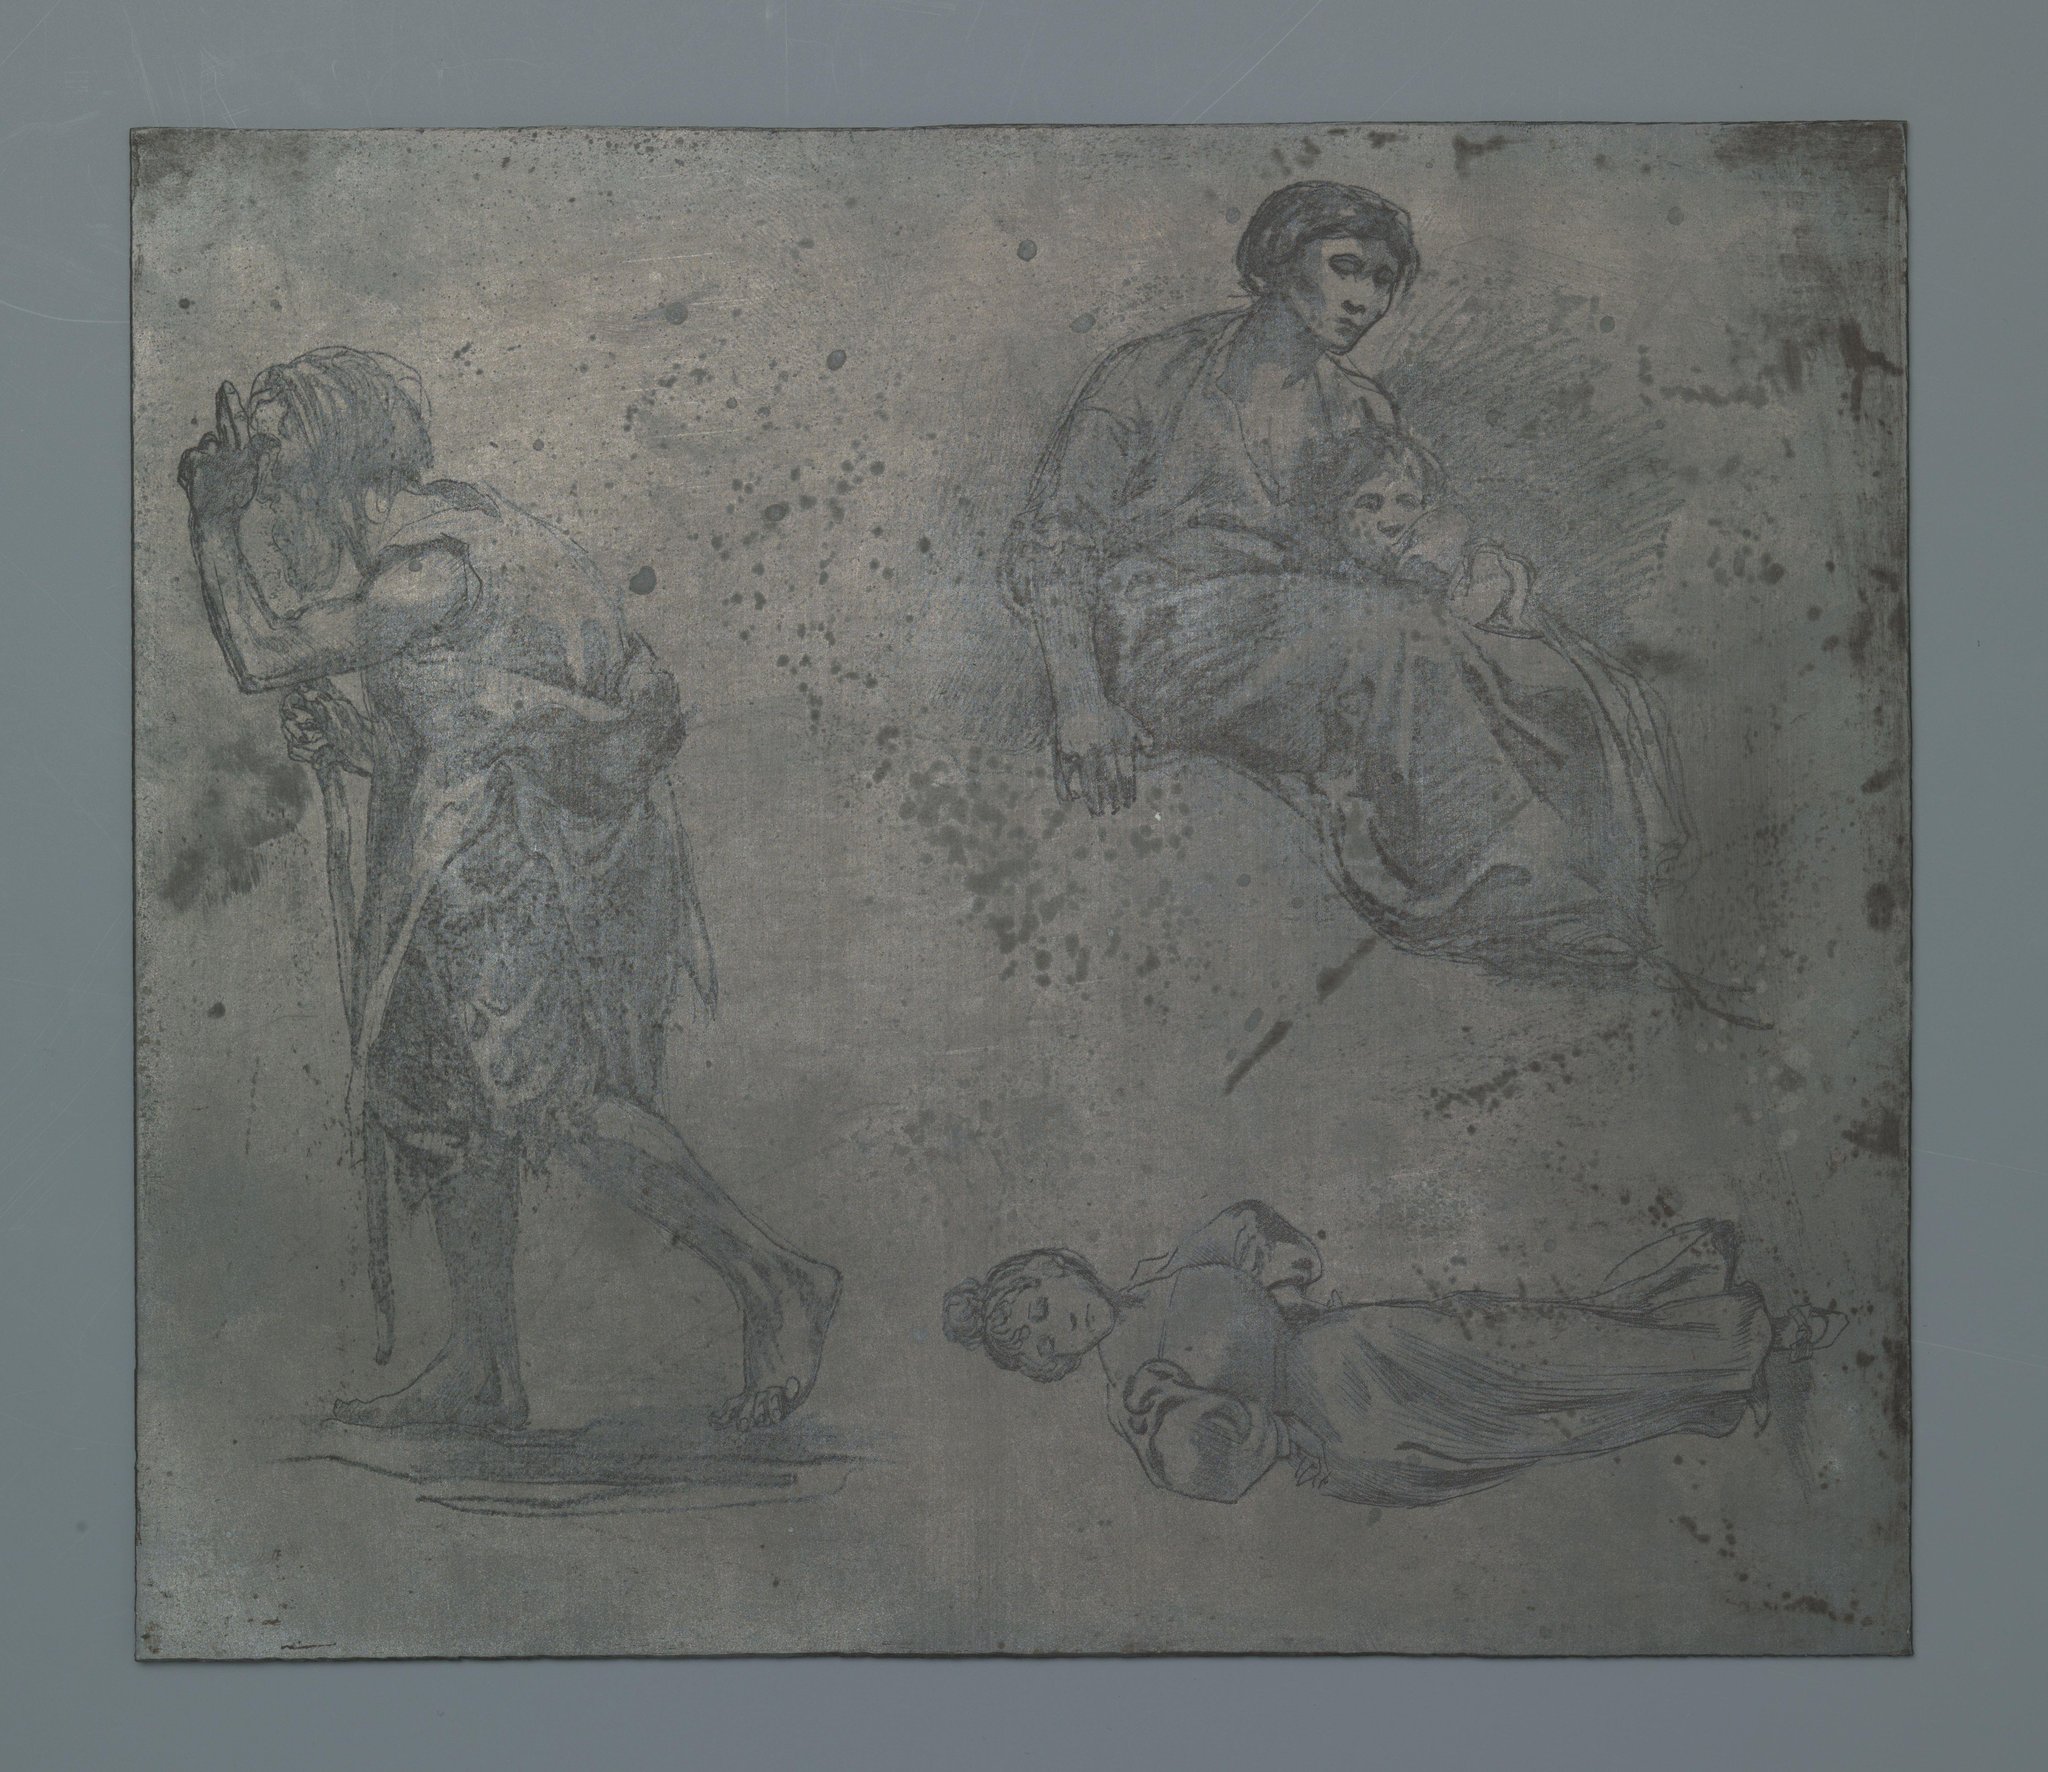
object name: zinkplaat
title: Moeder met kind, bedelaar, vrouw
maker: johannes josephus aarts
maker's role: draughtsman, print maker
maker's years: 1871-1934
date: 1881-1934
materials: zinc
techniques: soft ground etching